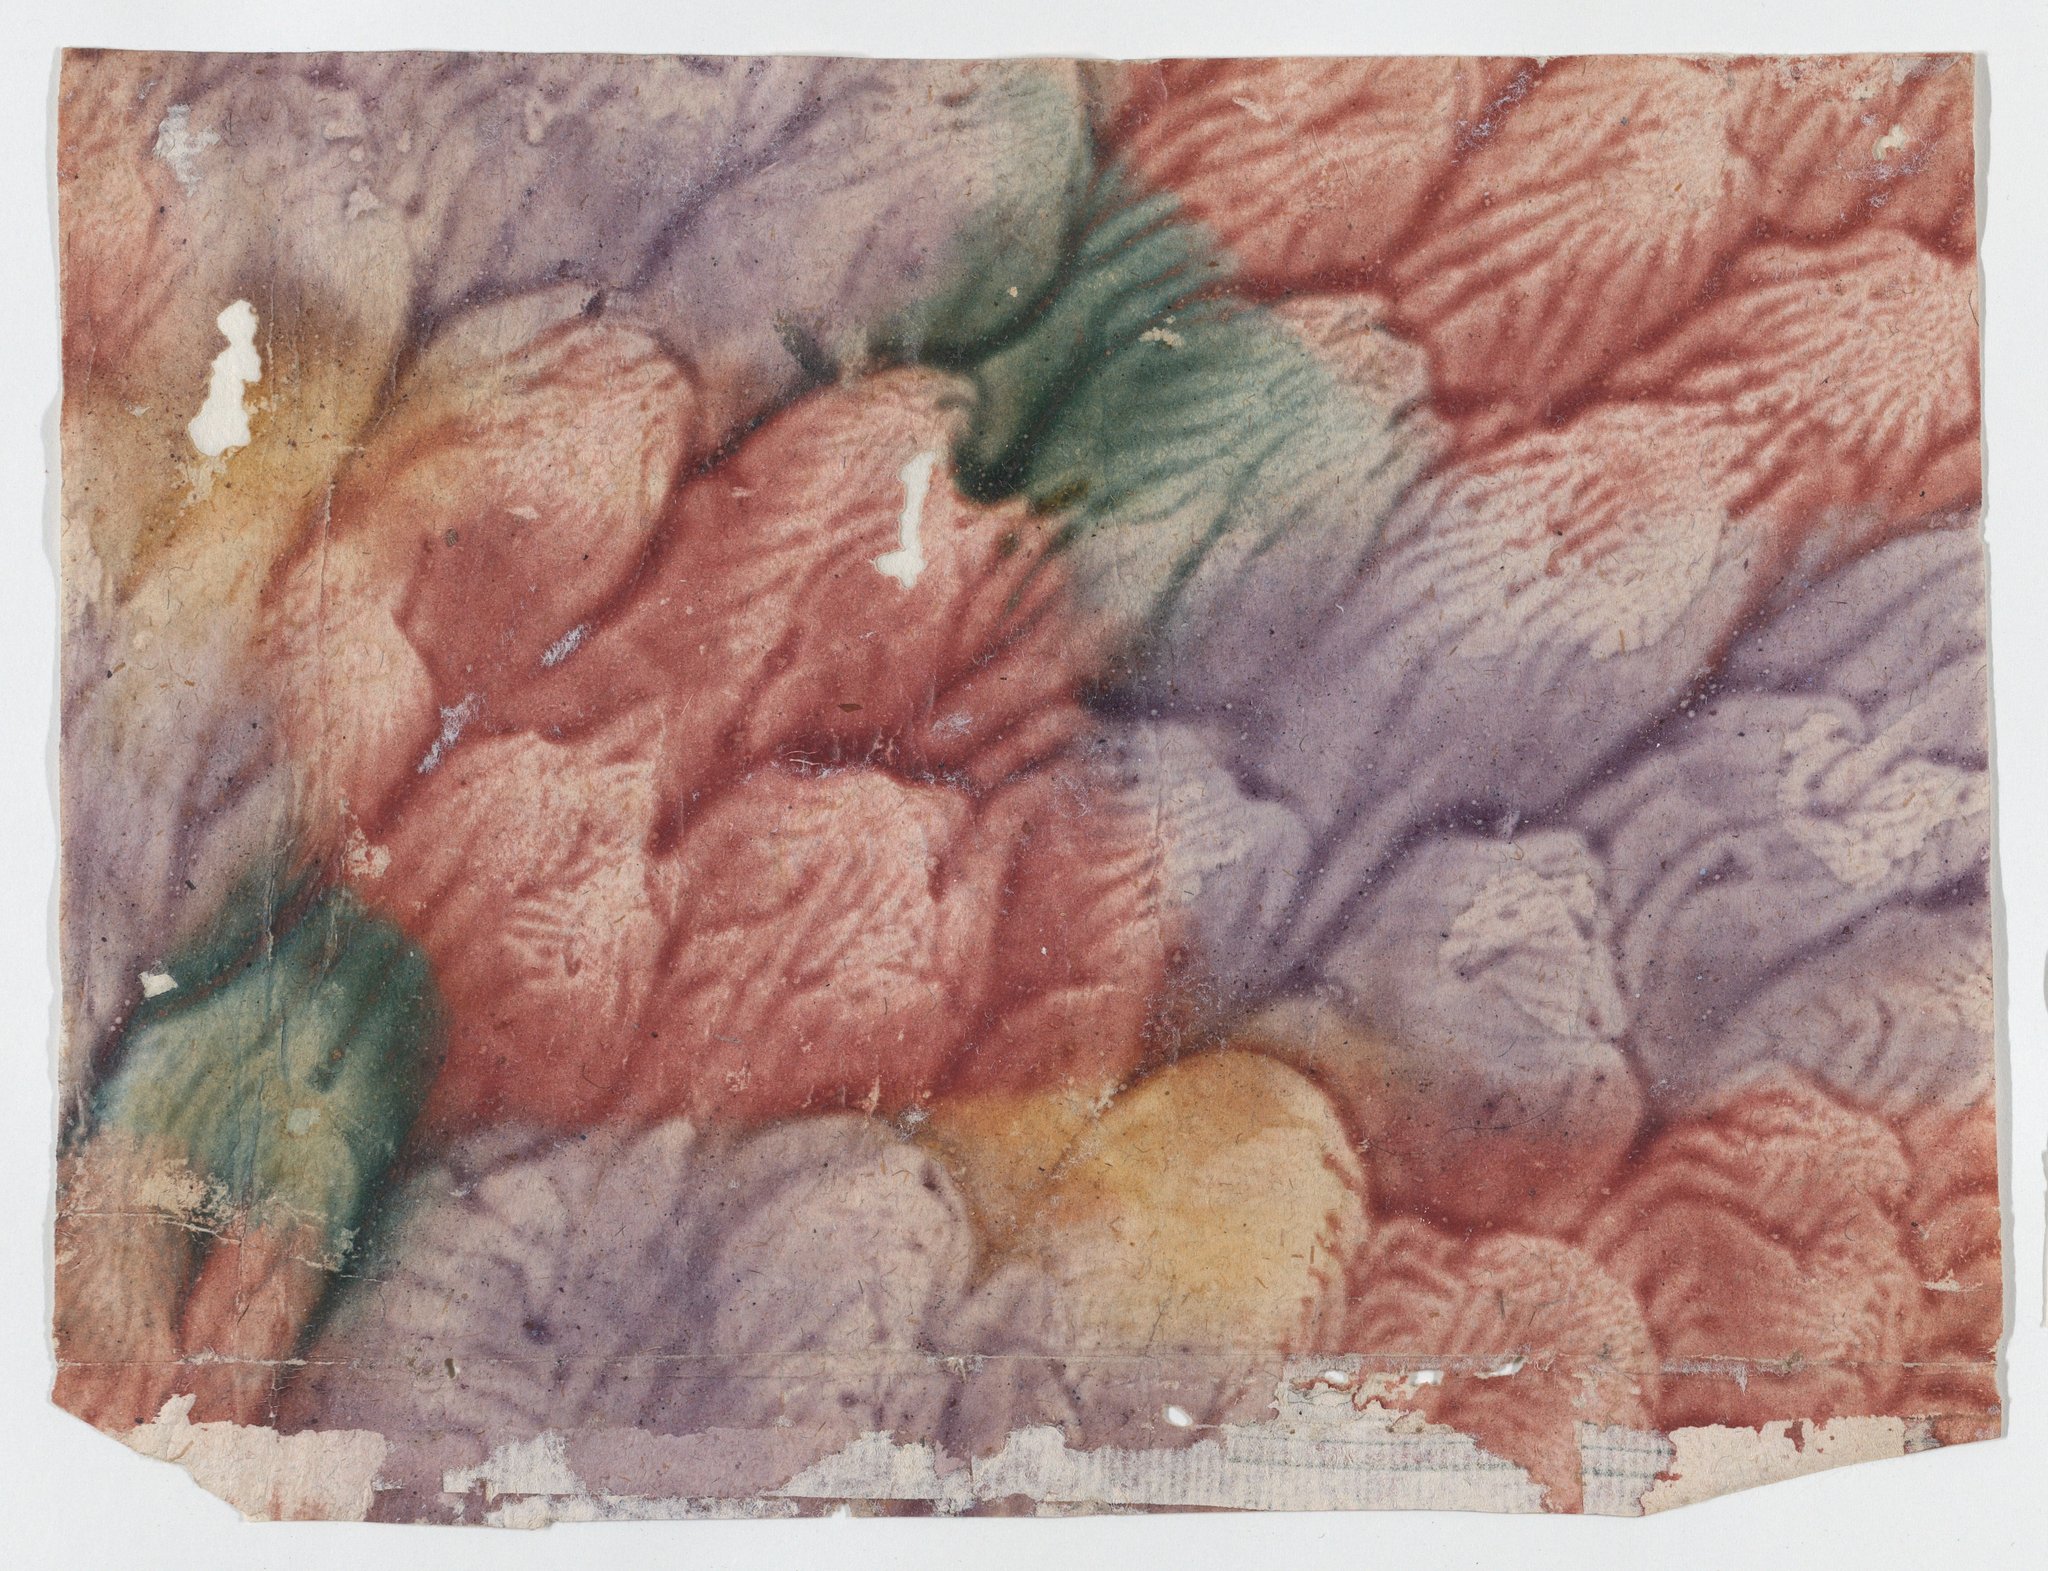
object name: print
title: Paste paper with red, purple, yellow, and green design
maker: Anonymous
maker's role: artist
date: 1701-1800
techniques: relief print